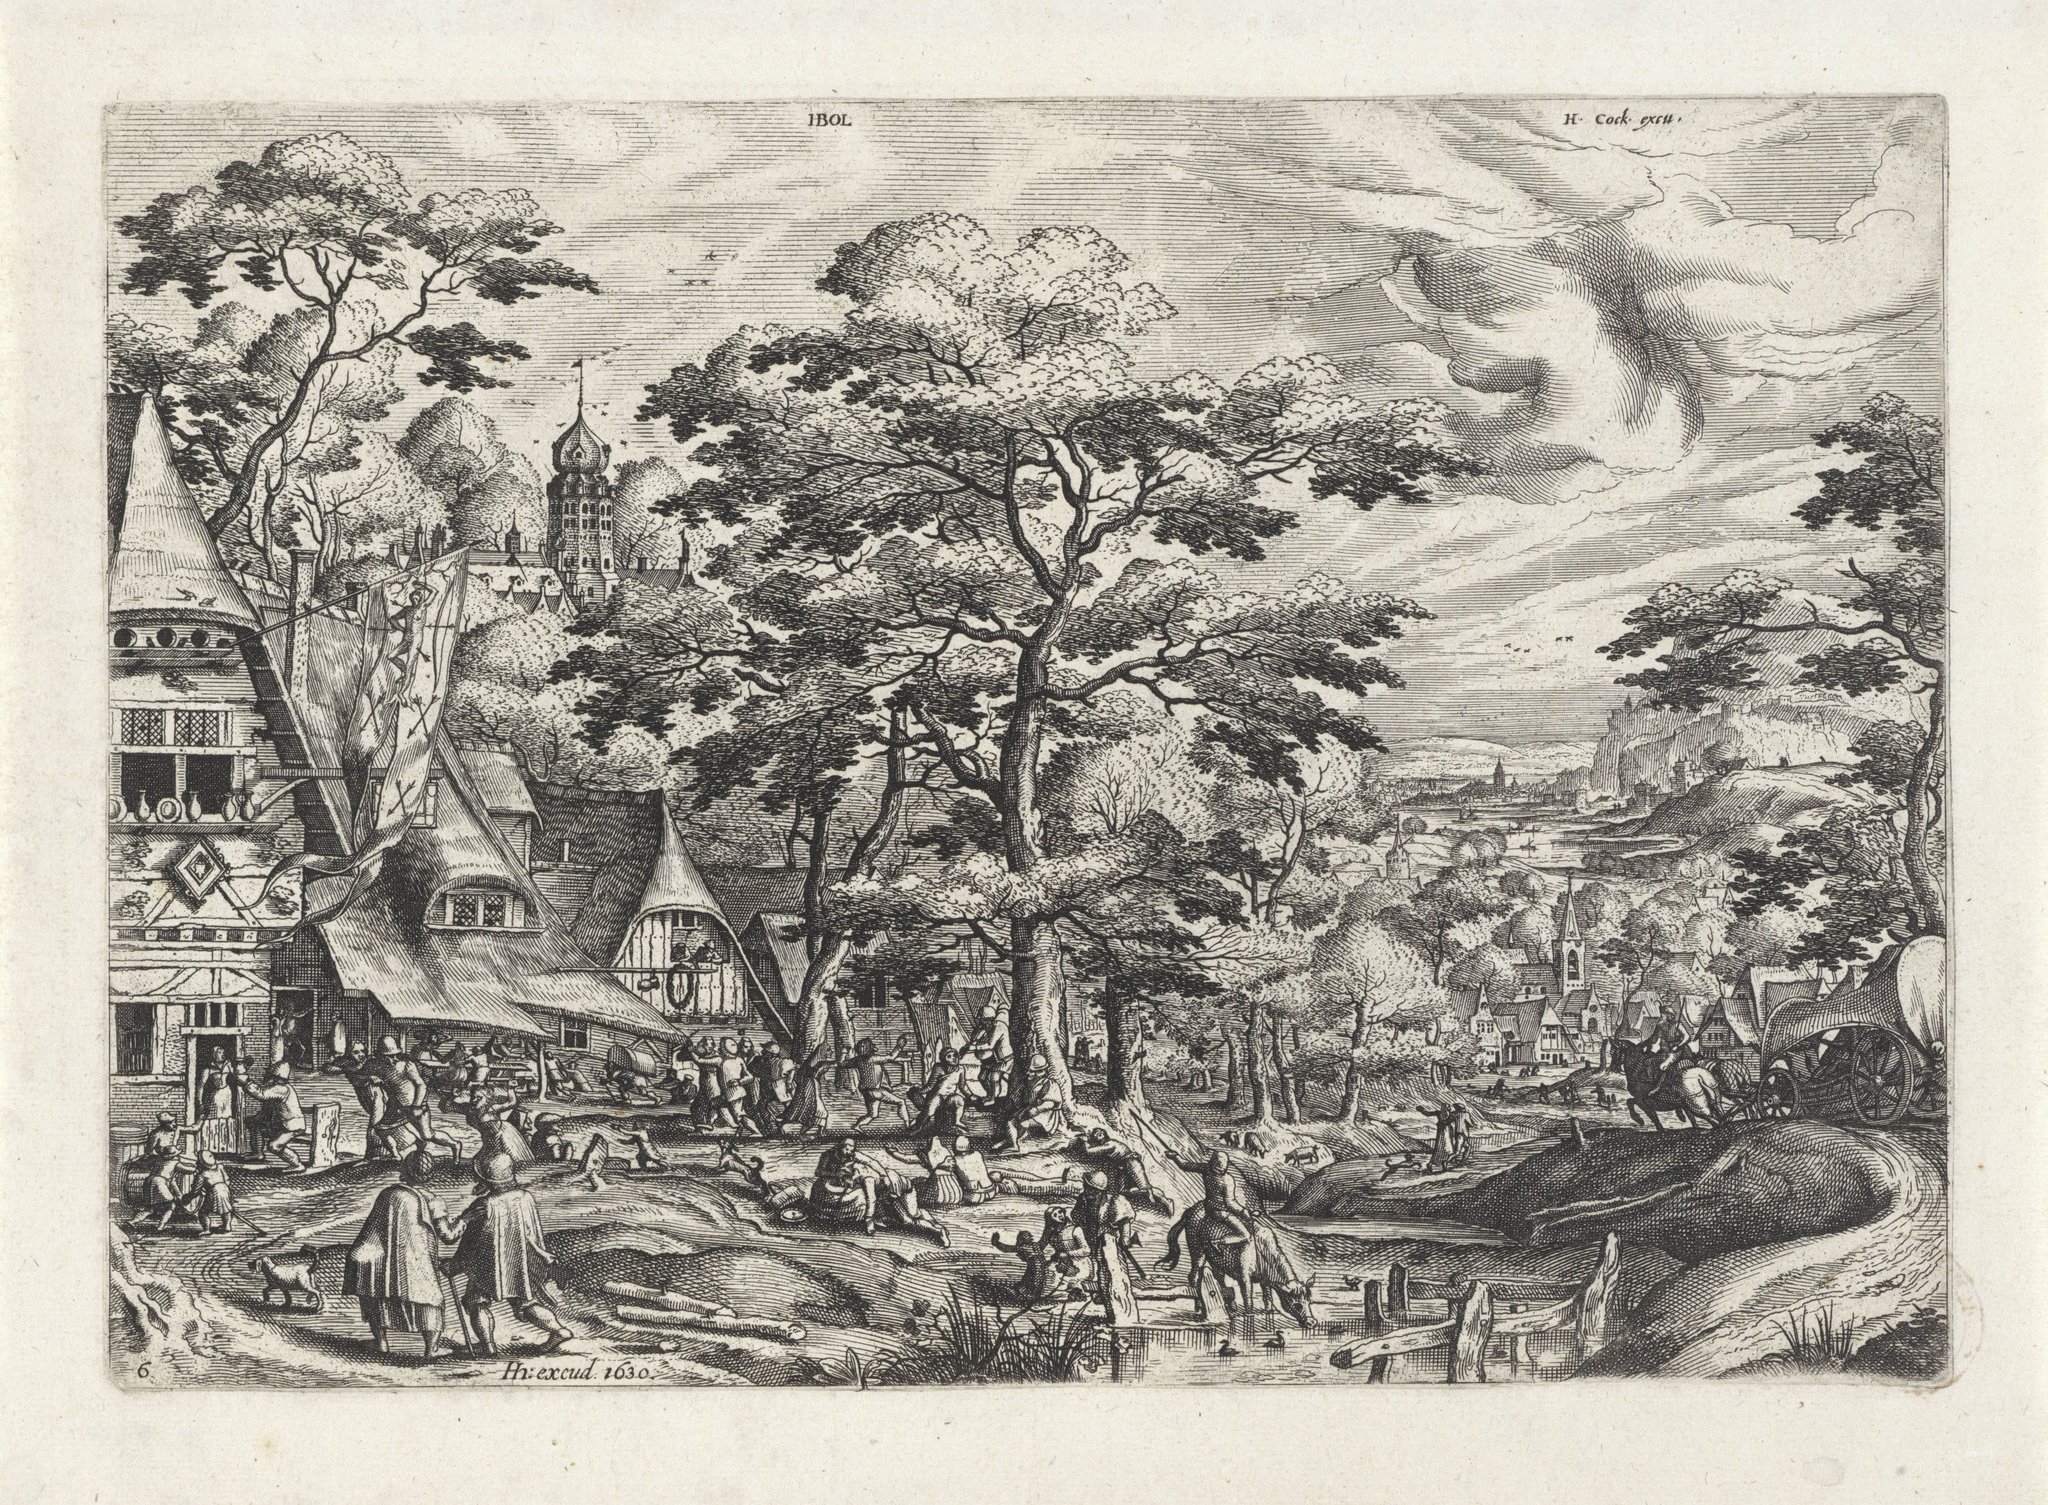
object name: print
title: Rivierlandschappen met bebouwing en figuren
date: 1630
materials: paper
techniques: etching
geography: low countries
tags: public festivities (+ eating and drinking ~ festive activities), inn, coffee-house, public house, etc., covered wagon, hooded wagon, celebration meal, feast, banquet - cc - out of doors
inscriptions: collector's mark: Lugt 240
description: Voor een herberg met een vlag waarop de H. Sebastiaan vieren boeren feest. Rechts trekken twee paarden een gehuifde kar over een landweg. Verder ligt dorp en in de verte stroomt een rivier door een bergdal.